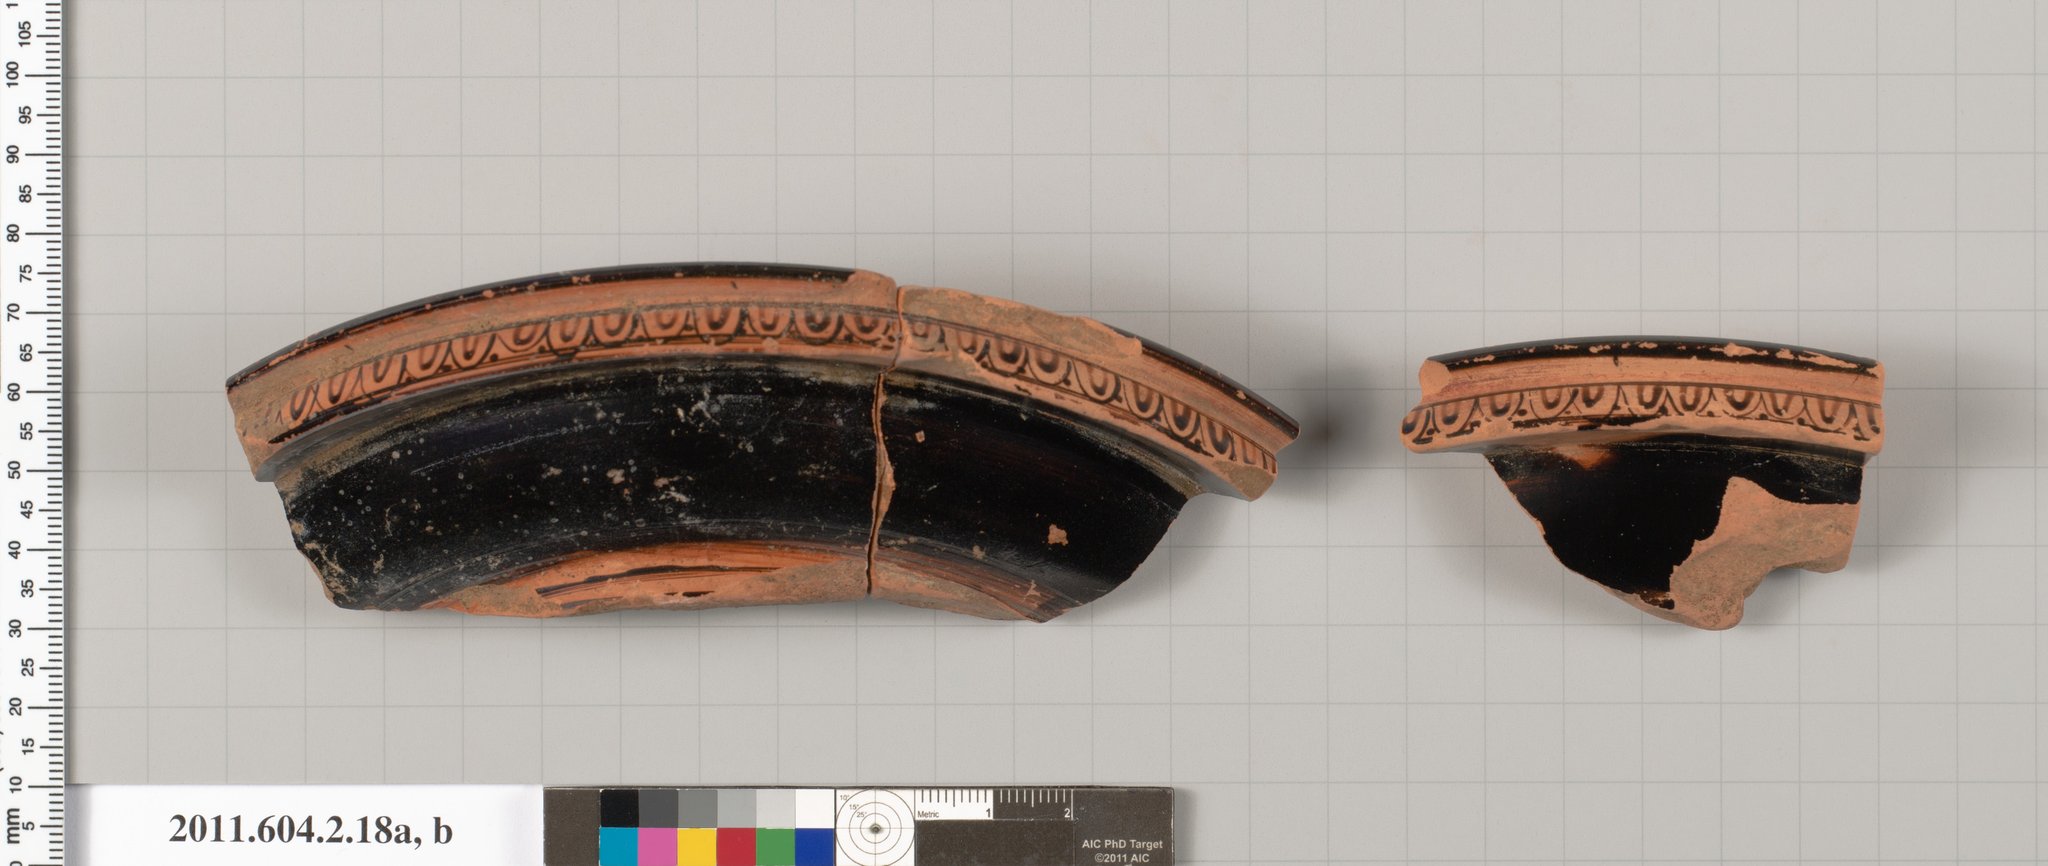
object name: neck amphora fragment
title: Terracotta fragments of a neck-amphora (jar)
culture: greek, attic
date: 475-451 BCE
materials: terracotta